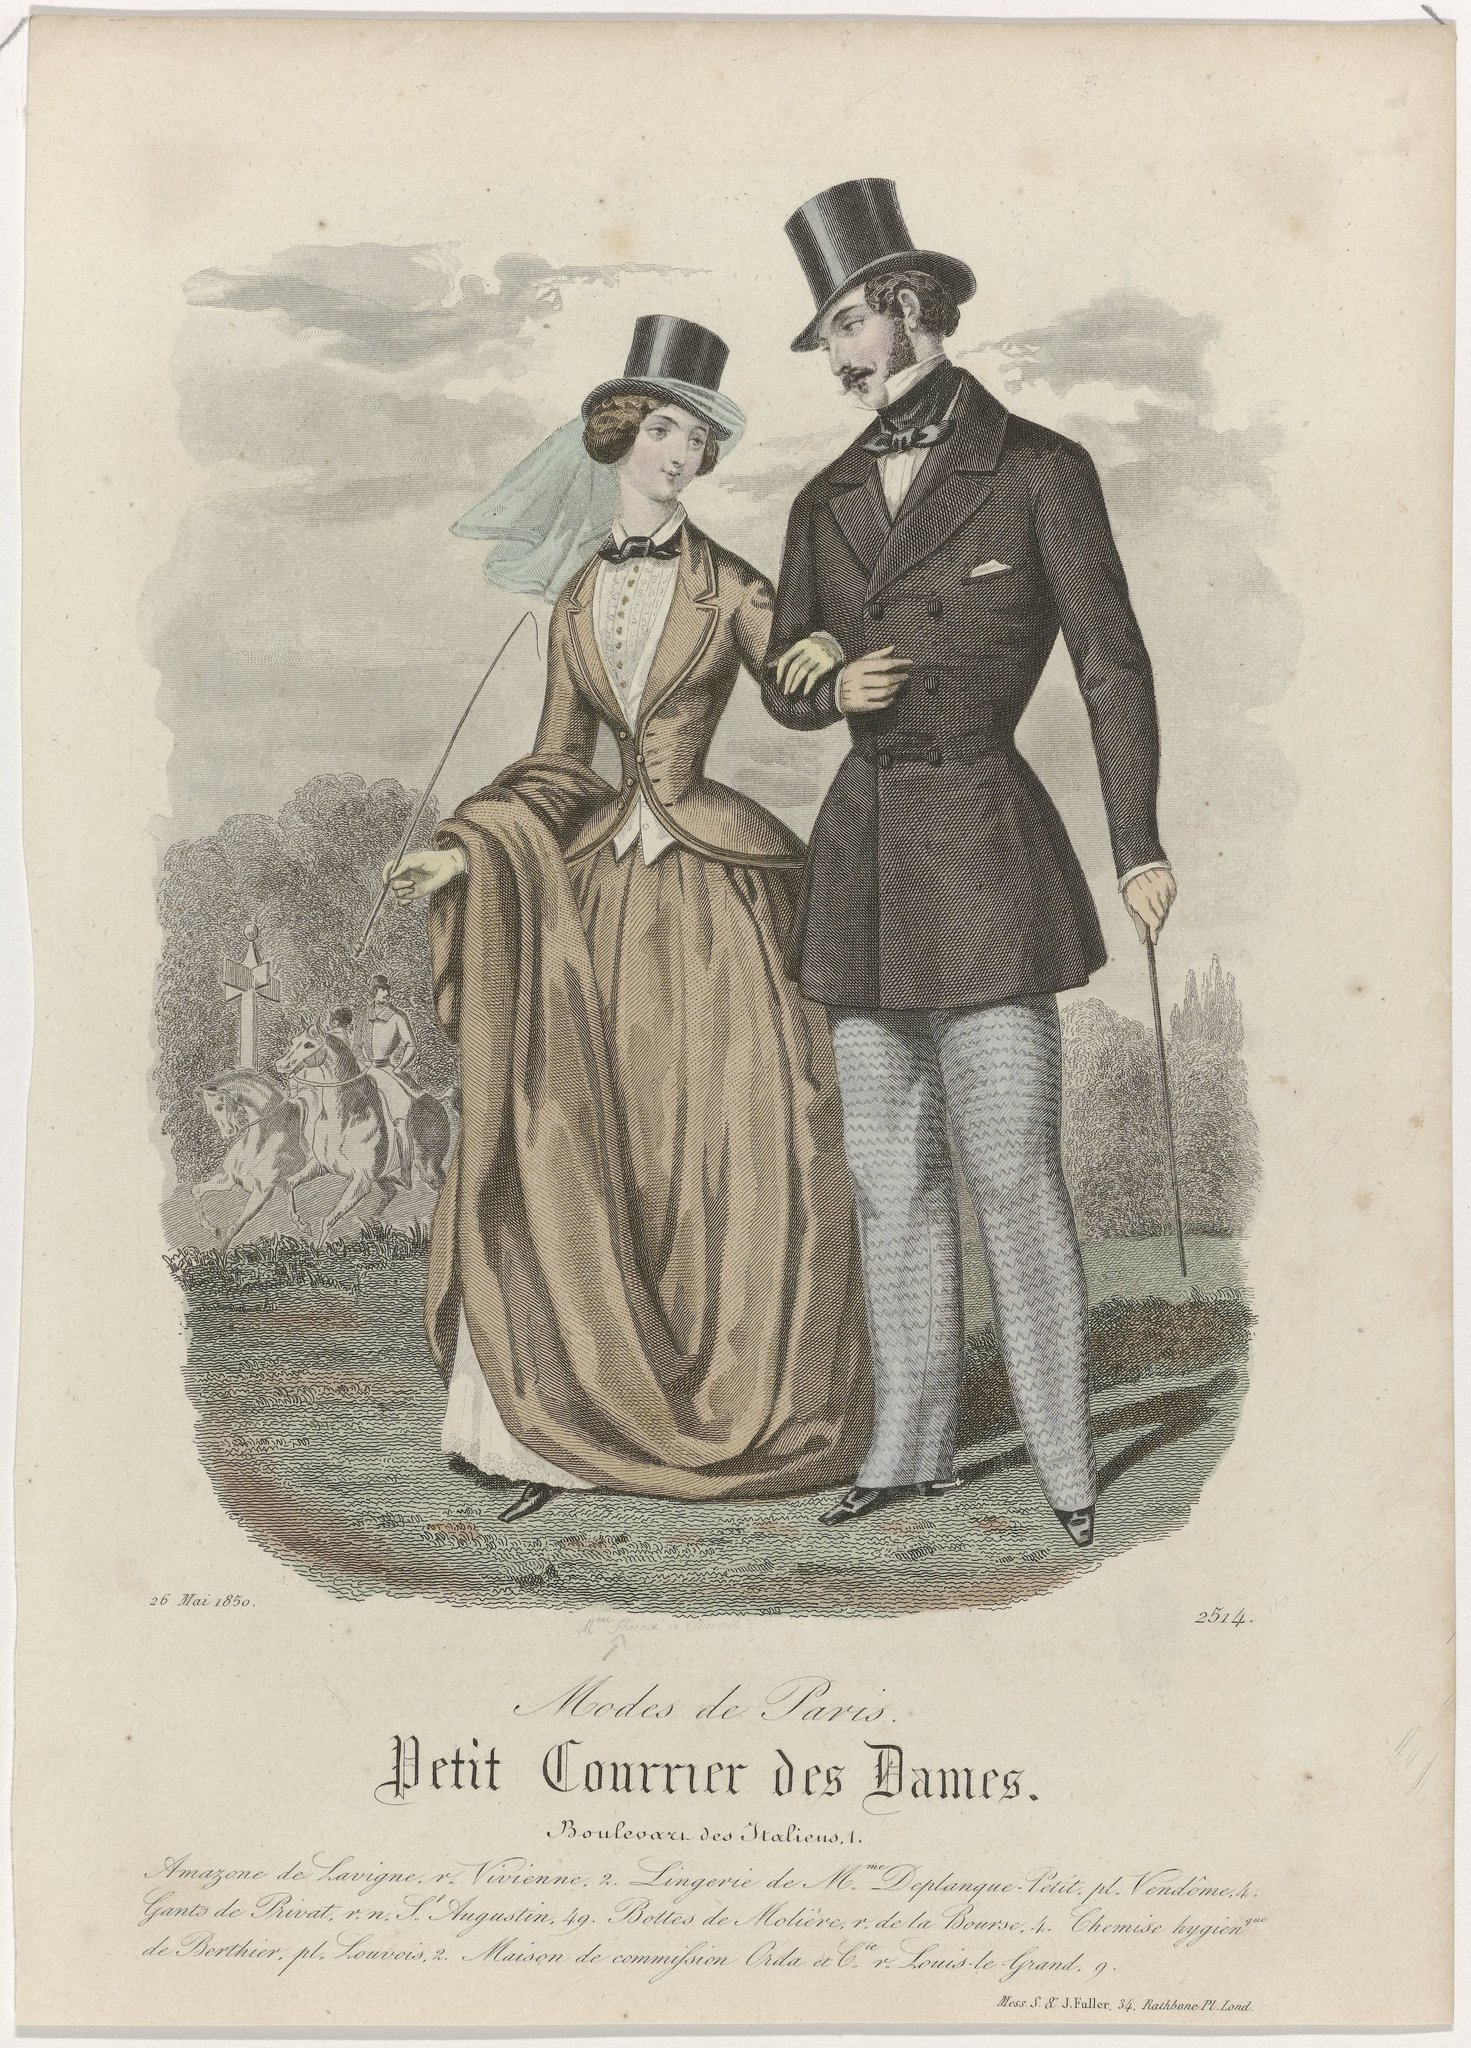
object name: fashion print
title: Petit Courrier des Dames, 26 mai 1850, No. 2514 : Amazone de Lavign (...)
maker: florensa de closménil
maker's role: print maker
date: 1850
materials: paper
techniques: engraving, hand coloring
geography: london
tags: riding a horse, ass, or mule; rider, horseman (+ variant), veil (+ women's clothes), underclothes for the lower part of the body (underskirt) (+ women's clothes), trousers, breeches, etc. (pantalon) (+ men's clothes), coat (+ women's clothes), coat (+ men's clothes), fashion plates, skirt (+ women's clothes), spur, horse in motion, whip, ensembles of pieces of clothing (riding costume) (+ women's clothes)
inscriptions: title: ‘Modes de Paris. / Petit Courrier des Dames.’, address: ‘Boulevart des Italiens, 1. / Mess. S. & J. Fuller, 34 Rathbone Pl. Lond.’, caption: ‘Amazone de Lavigne, r" Vivienne, 2. Lingerie de M"me Deplanque-Petit, pl" Vendôme,4. Gants de Privat, r"n"S"t Augustin, 49. Bottes de Molière, r"de la Bourse, 4. Chemise hygienque de Berthier, pl"Louvois, 2. Maison de commission Orda et C"ie r" Louis-le -Grand, 9.’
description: Een gearmd paar. De vrouw draagt een rijkostuum. Met de rechterhand houdt ze haar rok op, waardoor haar onderrok te zien is. Hoge hoed met sluier, rijzweep in de hand. De man draagt een double-breasted jas met kraag en revers op een lange broek. Hoge hoed en gestrikte halsdoek. Volgens het onderschrift: amazonekostuum van Lavigne. Hieronder enkele regels reclametekst voor verschillende accessoires. Prent uit het modetijdschrift Petit Courrier des Dames (1821-1868).